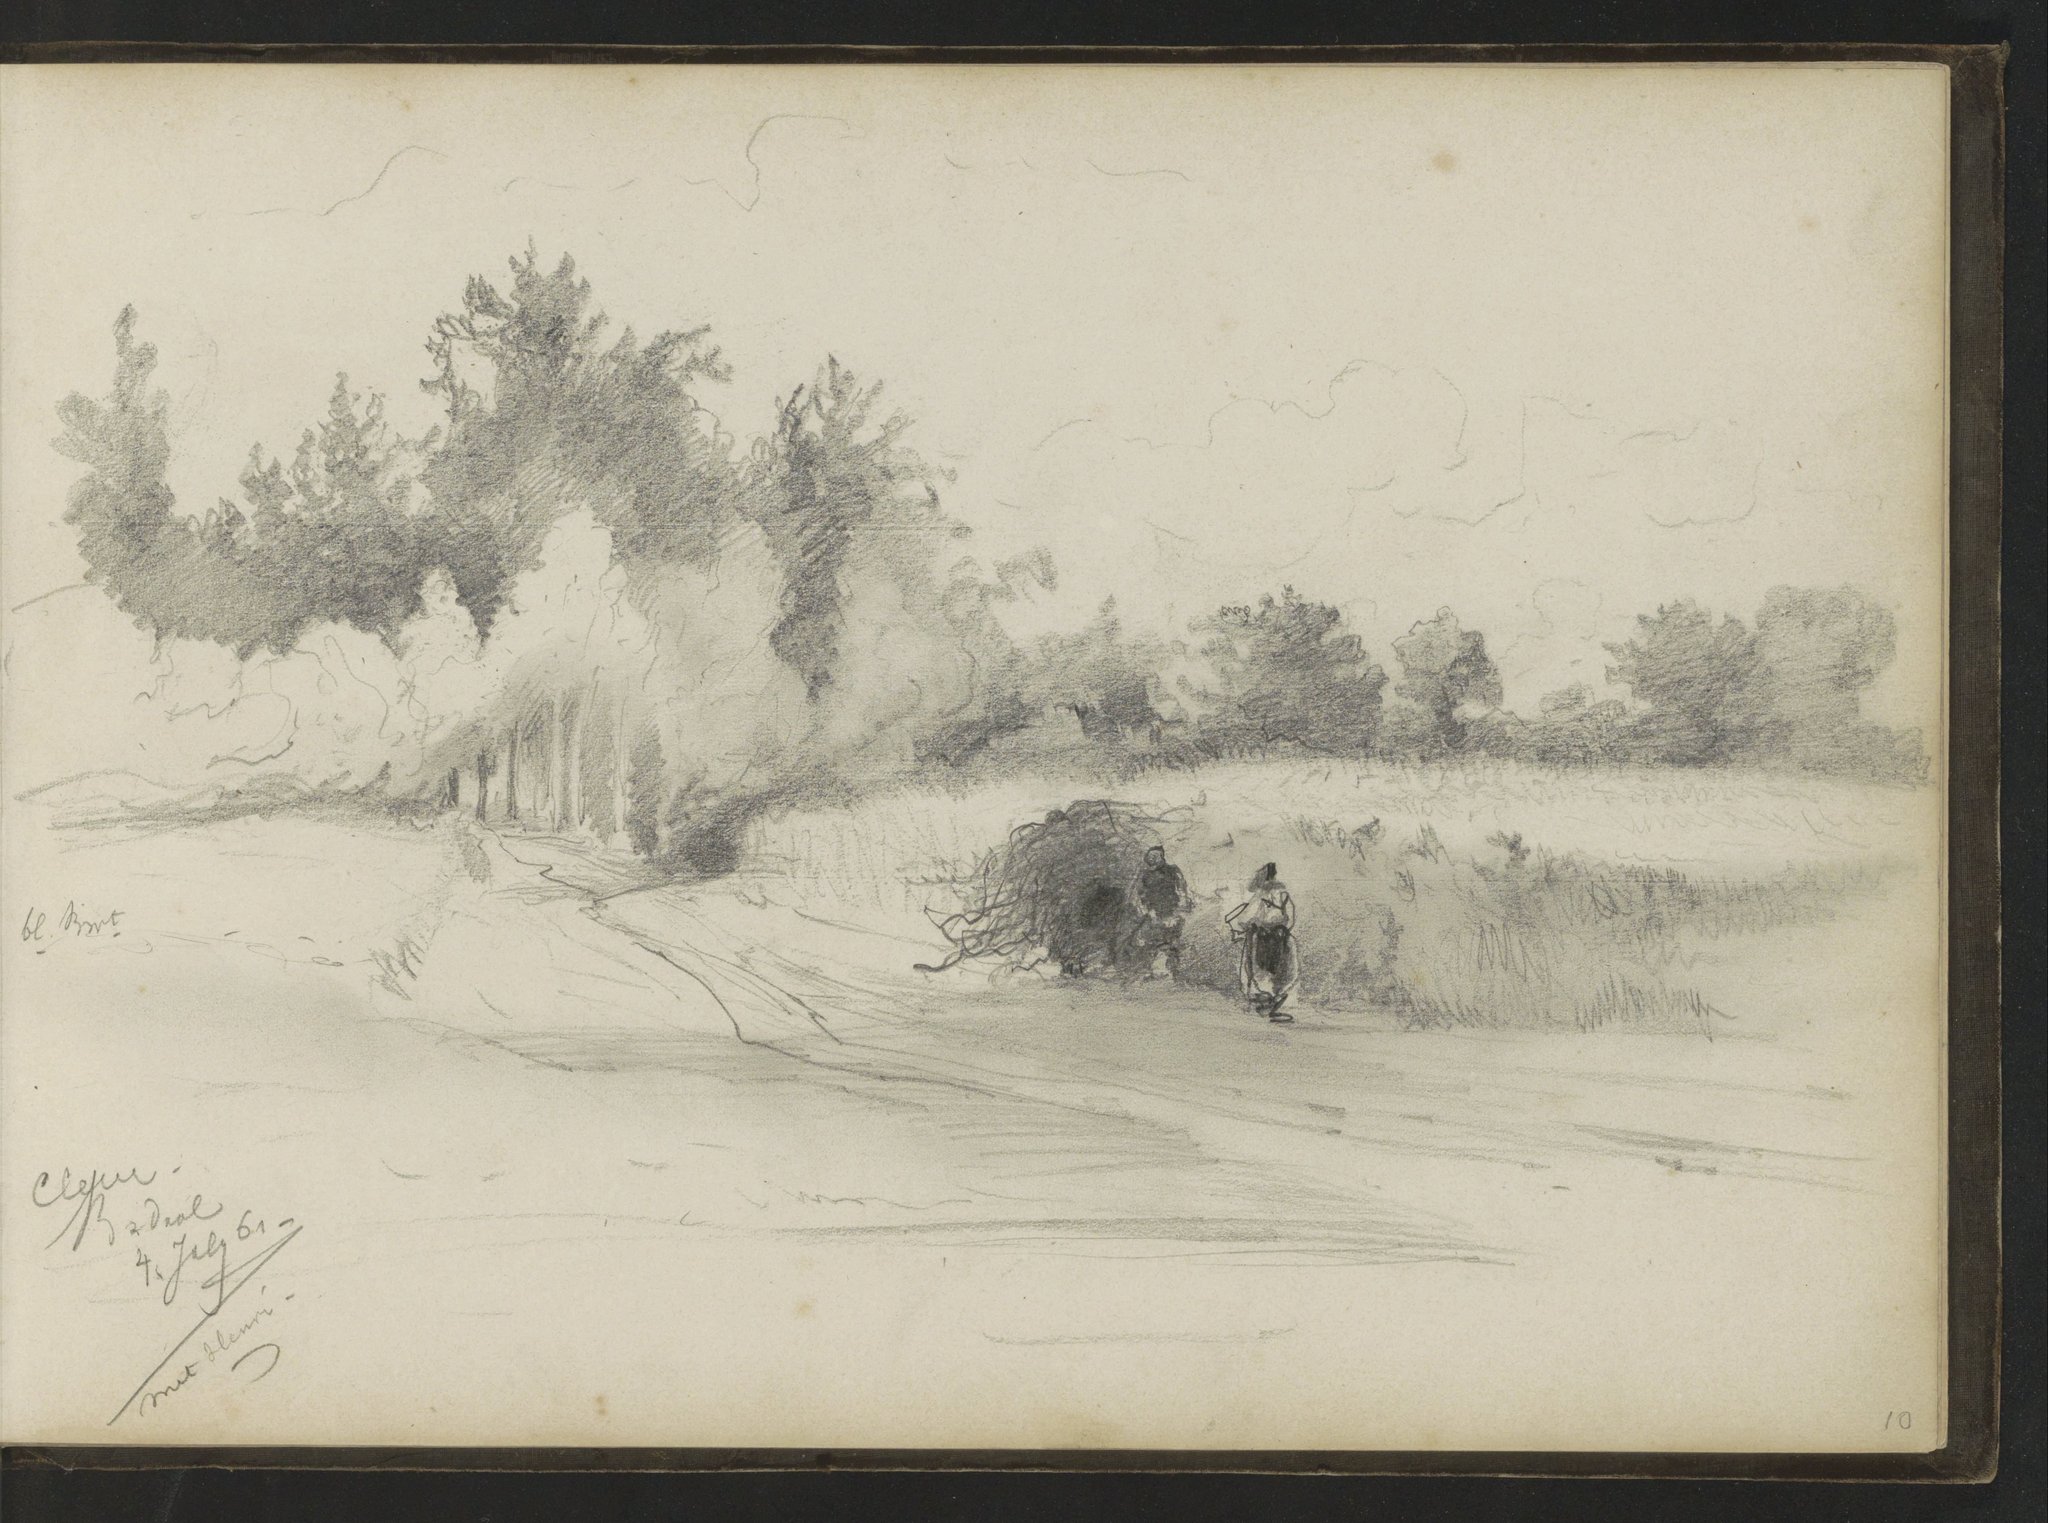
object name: sketchbook leaf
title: Landweg tussen Kleef en Berg en Dal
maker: johannes tavenraat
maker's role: draughtsman, painter, print maker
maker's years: 1809-1881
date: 1807-1861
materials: paper, pencil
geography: berg en dal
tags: trees, road, path, landscapes (+ landscape with figures, staffage), cleves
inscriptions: date and inscription: ‘6l B[...]nt/ Cleve/ B & Dal/ 4 July 61/ met Henri’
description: Naast de weg staan enkele figuren bij een veld. Blad 10 recto uit een schetsboek met 57 bladen.